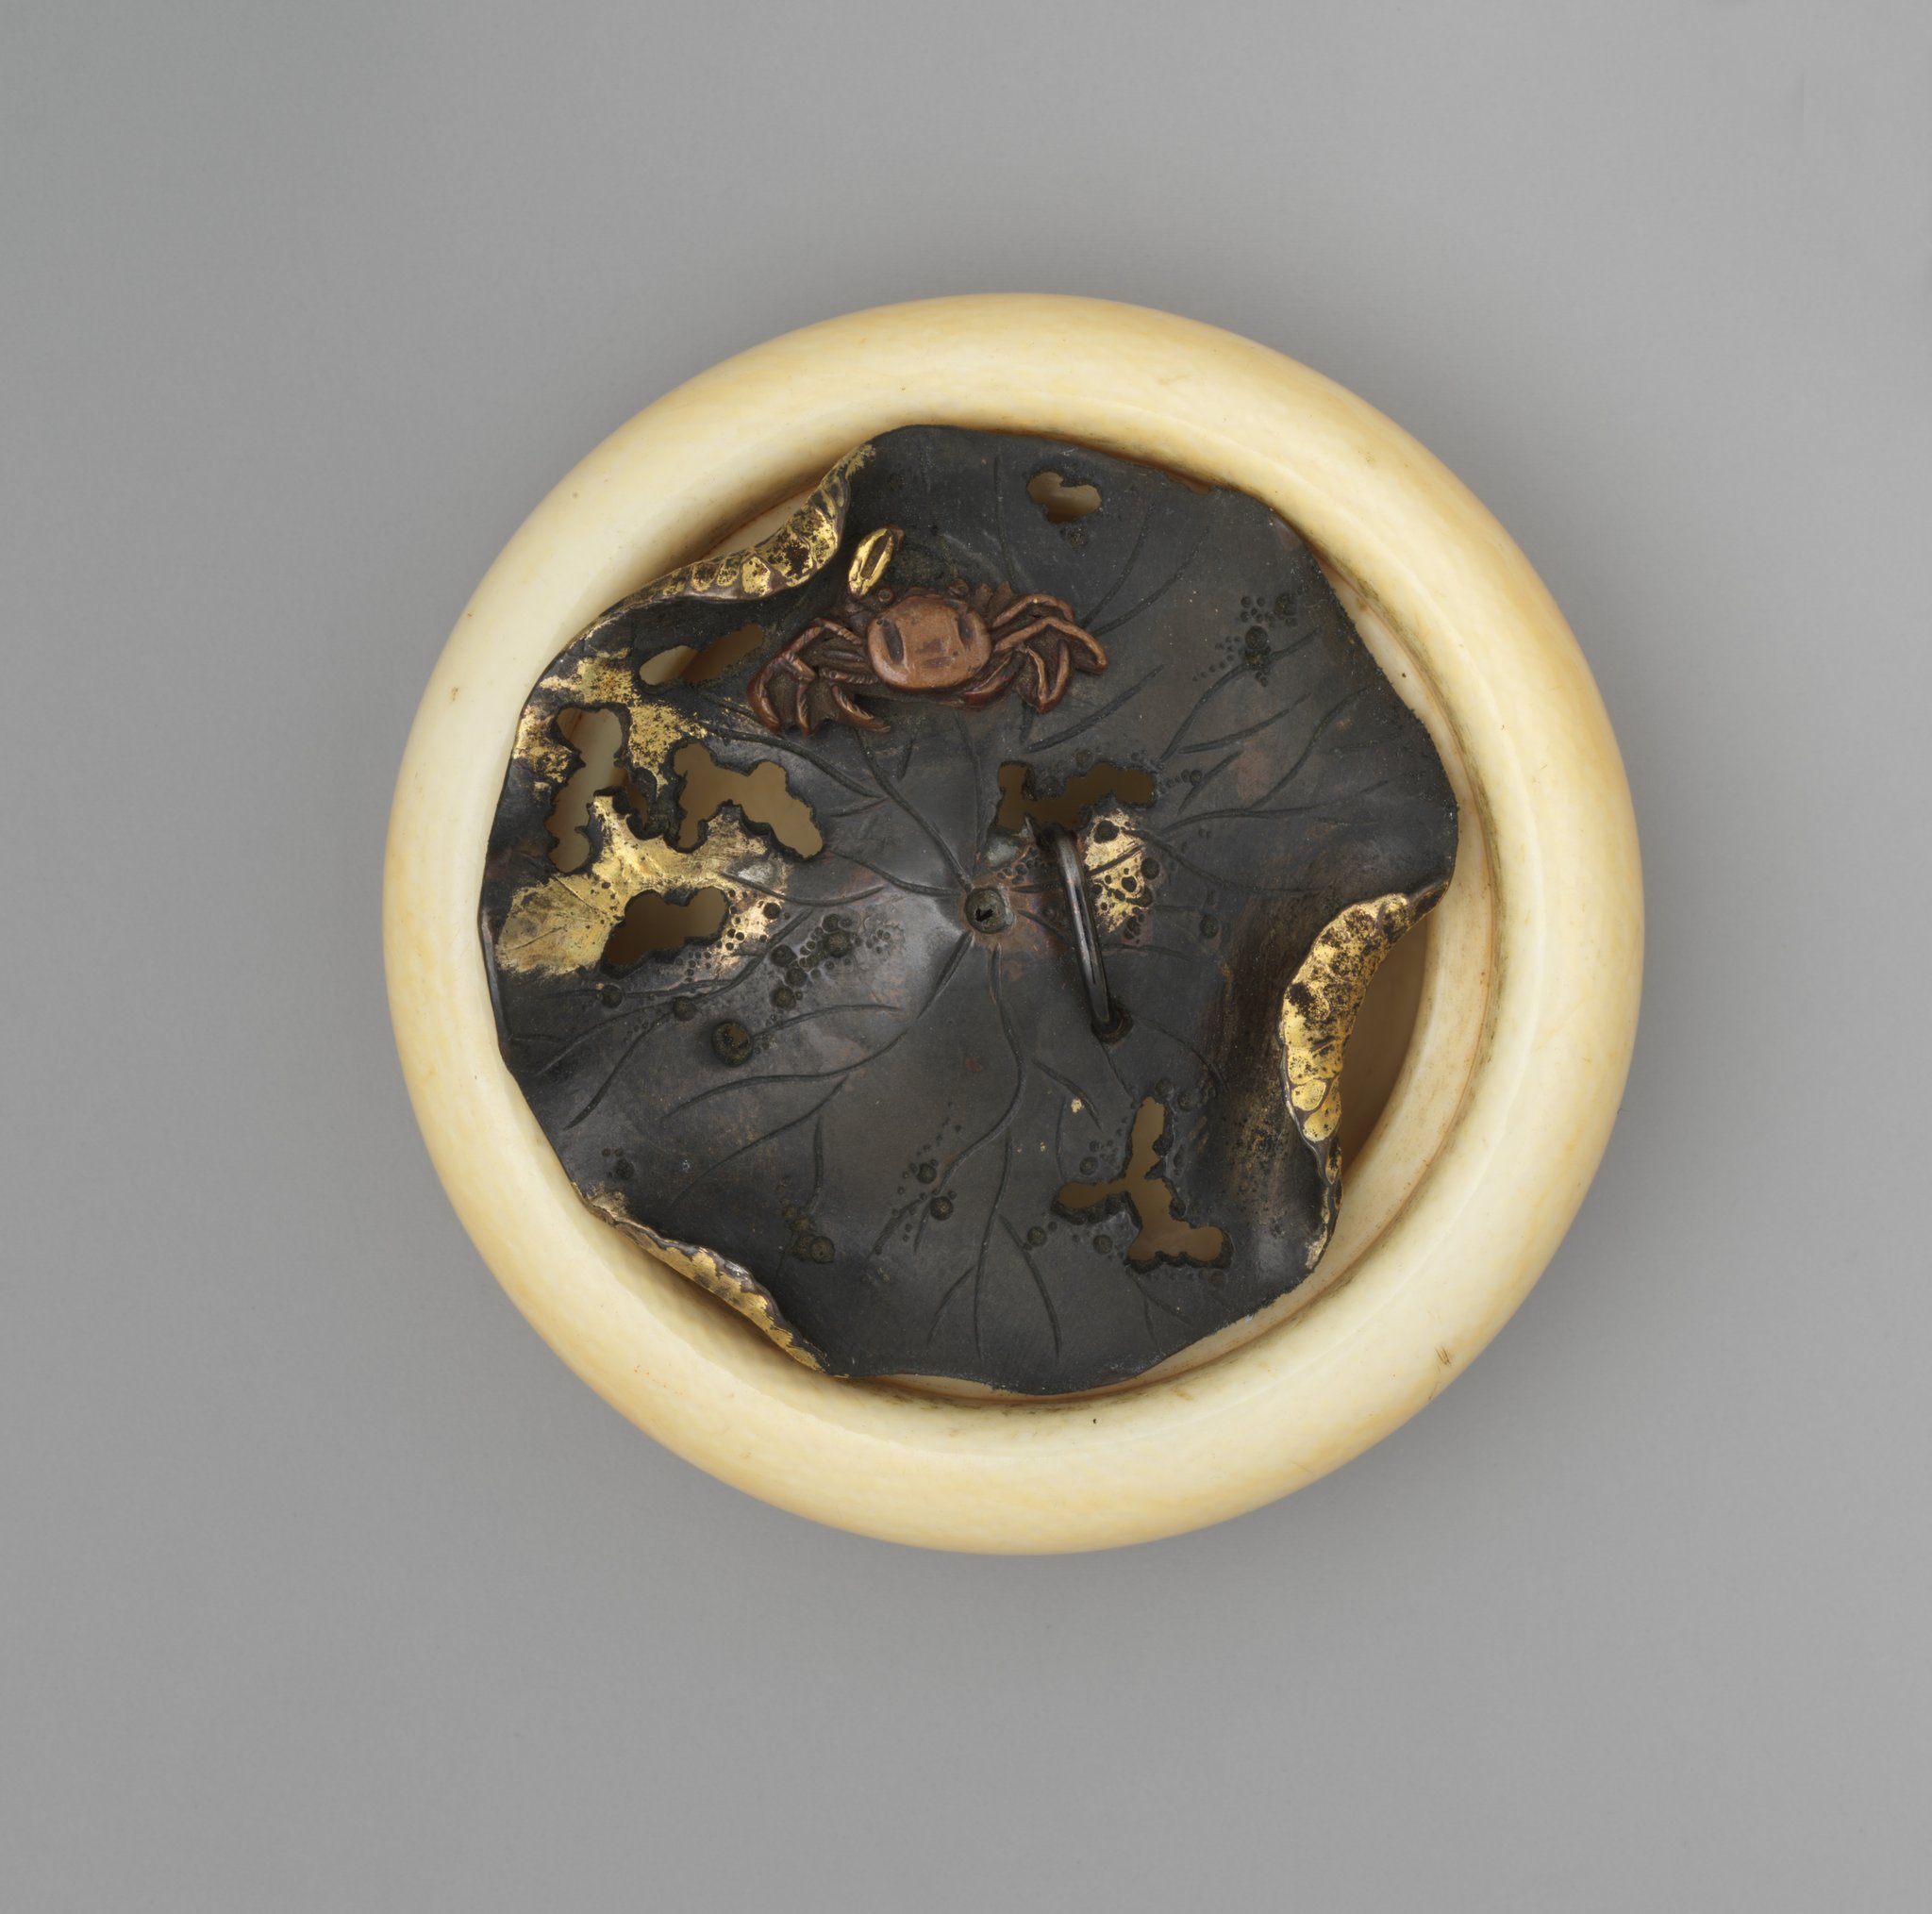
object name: netsuke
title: Crab on a Lotus Leaf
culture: japanese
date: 1801-1833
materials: copper, ivory, metal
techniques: gilding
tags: crabs,leaves